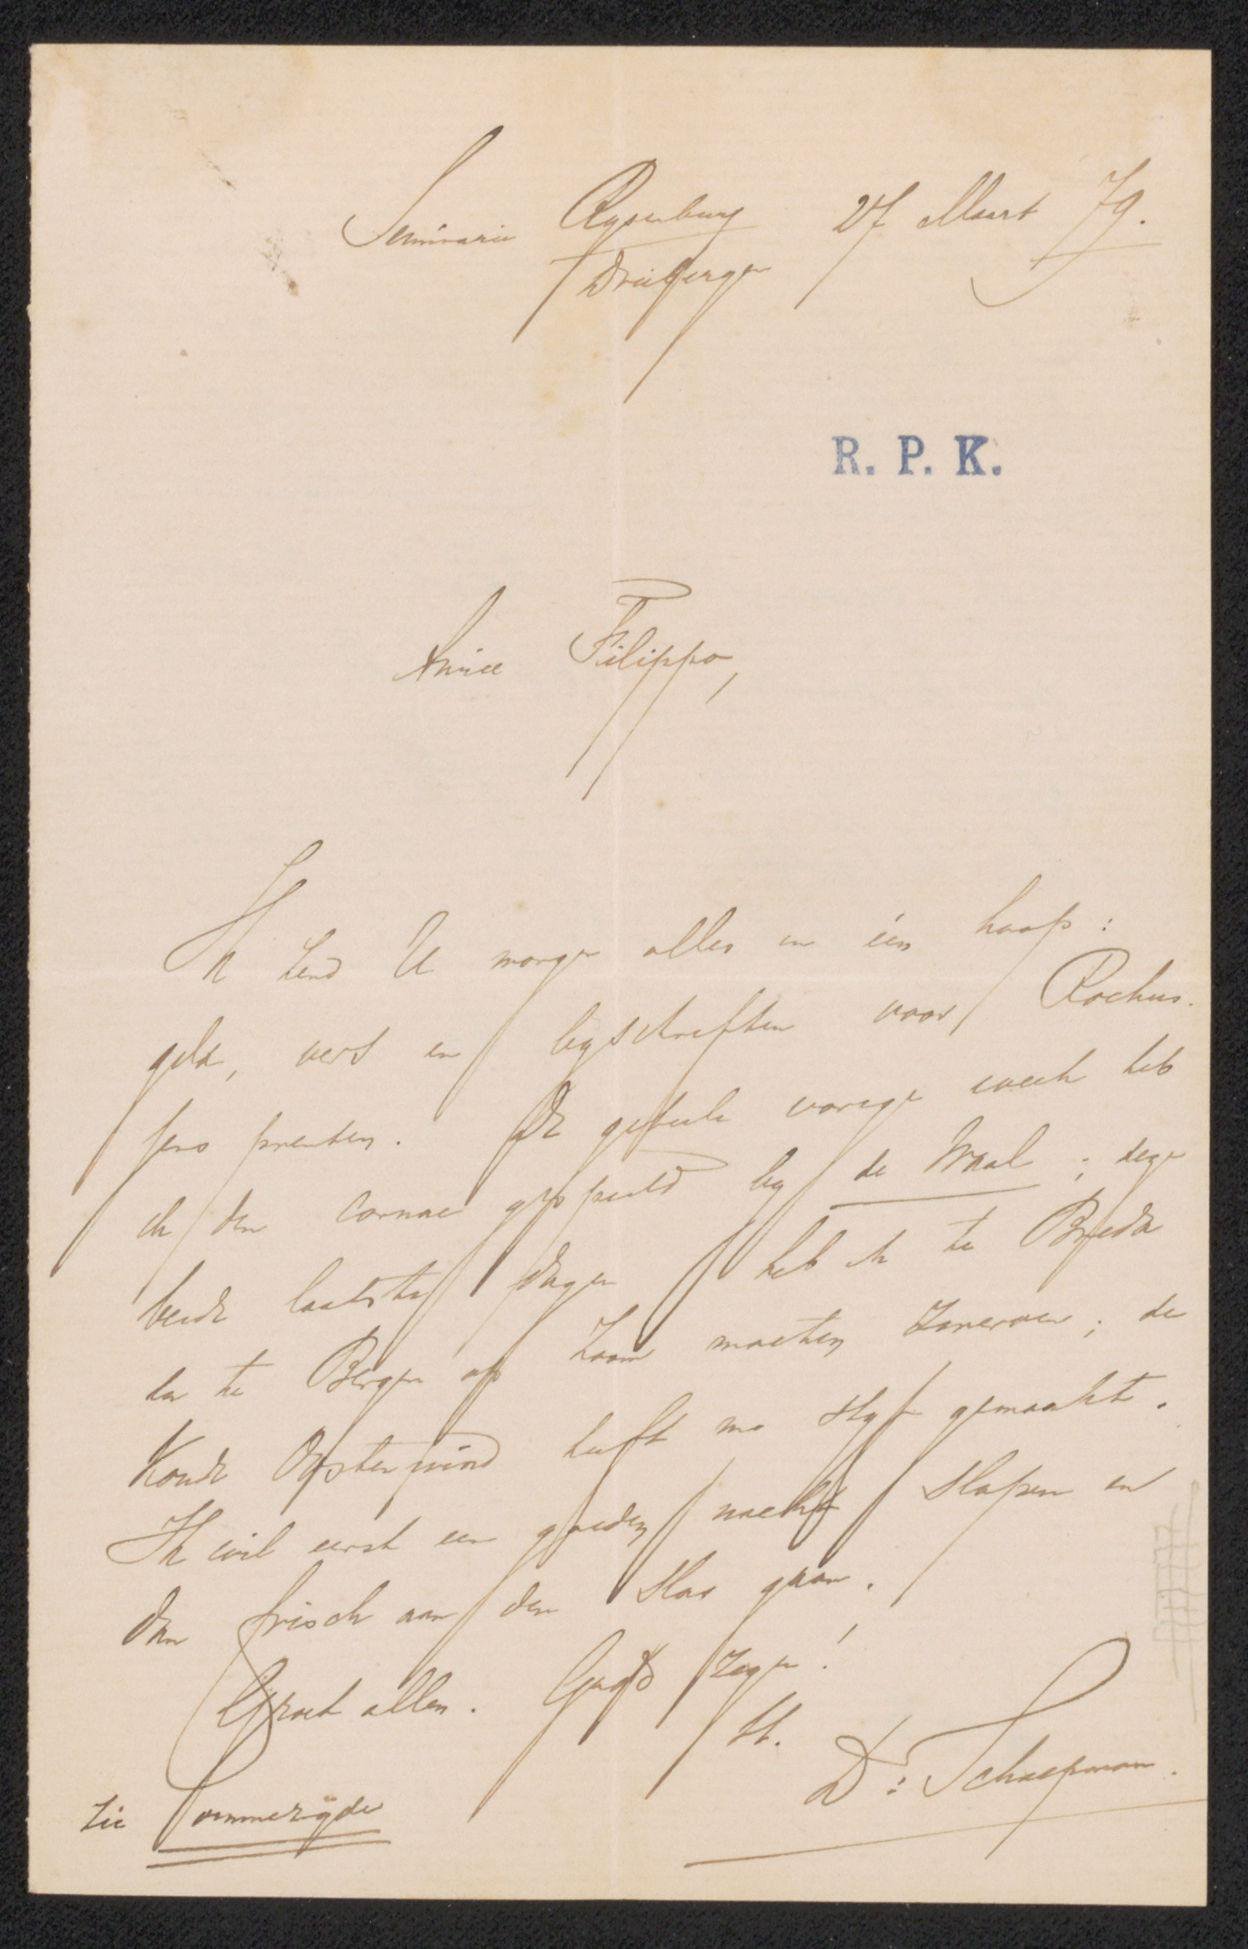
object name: letter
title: Brief aan Filippo Tessaro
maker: herman johannes aloysius maria schaepman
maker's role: priest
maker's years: 1844-1903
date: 1879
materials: ink, paper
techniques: pen, writing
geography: driebergen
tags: rotterdam, painter, print maker, draughtsman, charles rochussen, the graphic arts, bergen op zoom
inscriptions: collector's mark: Lugt 2233